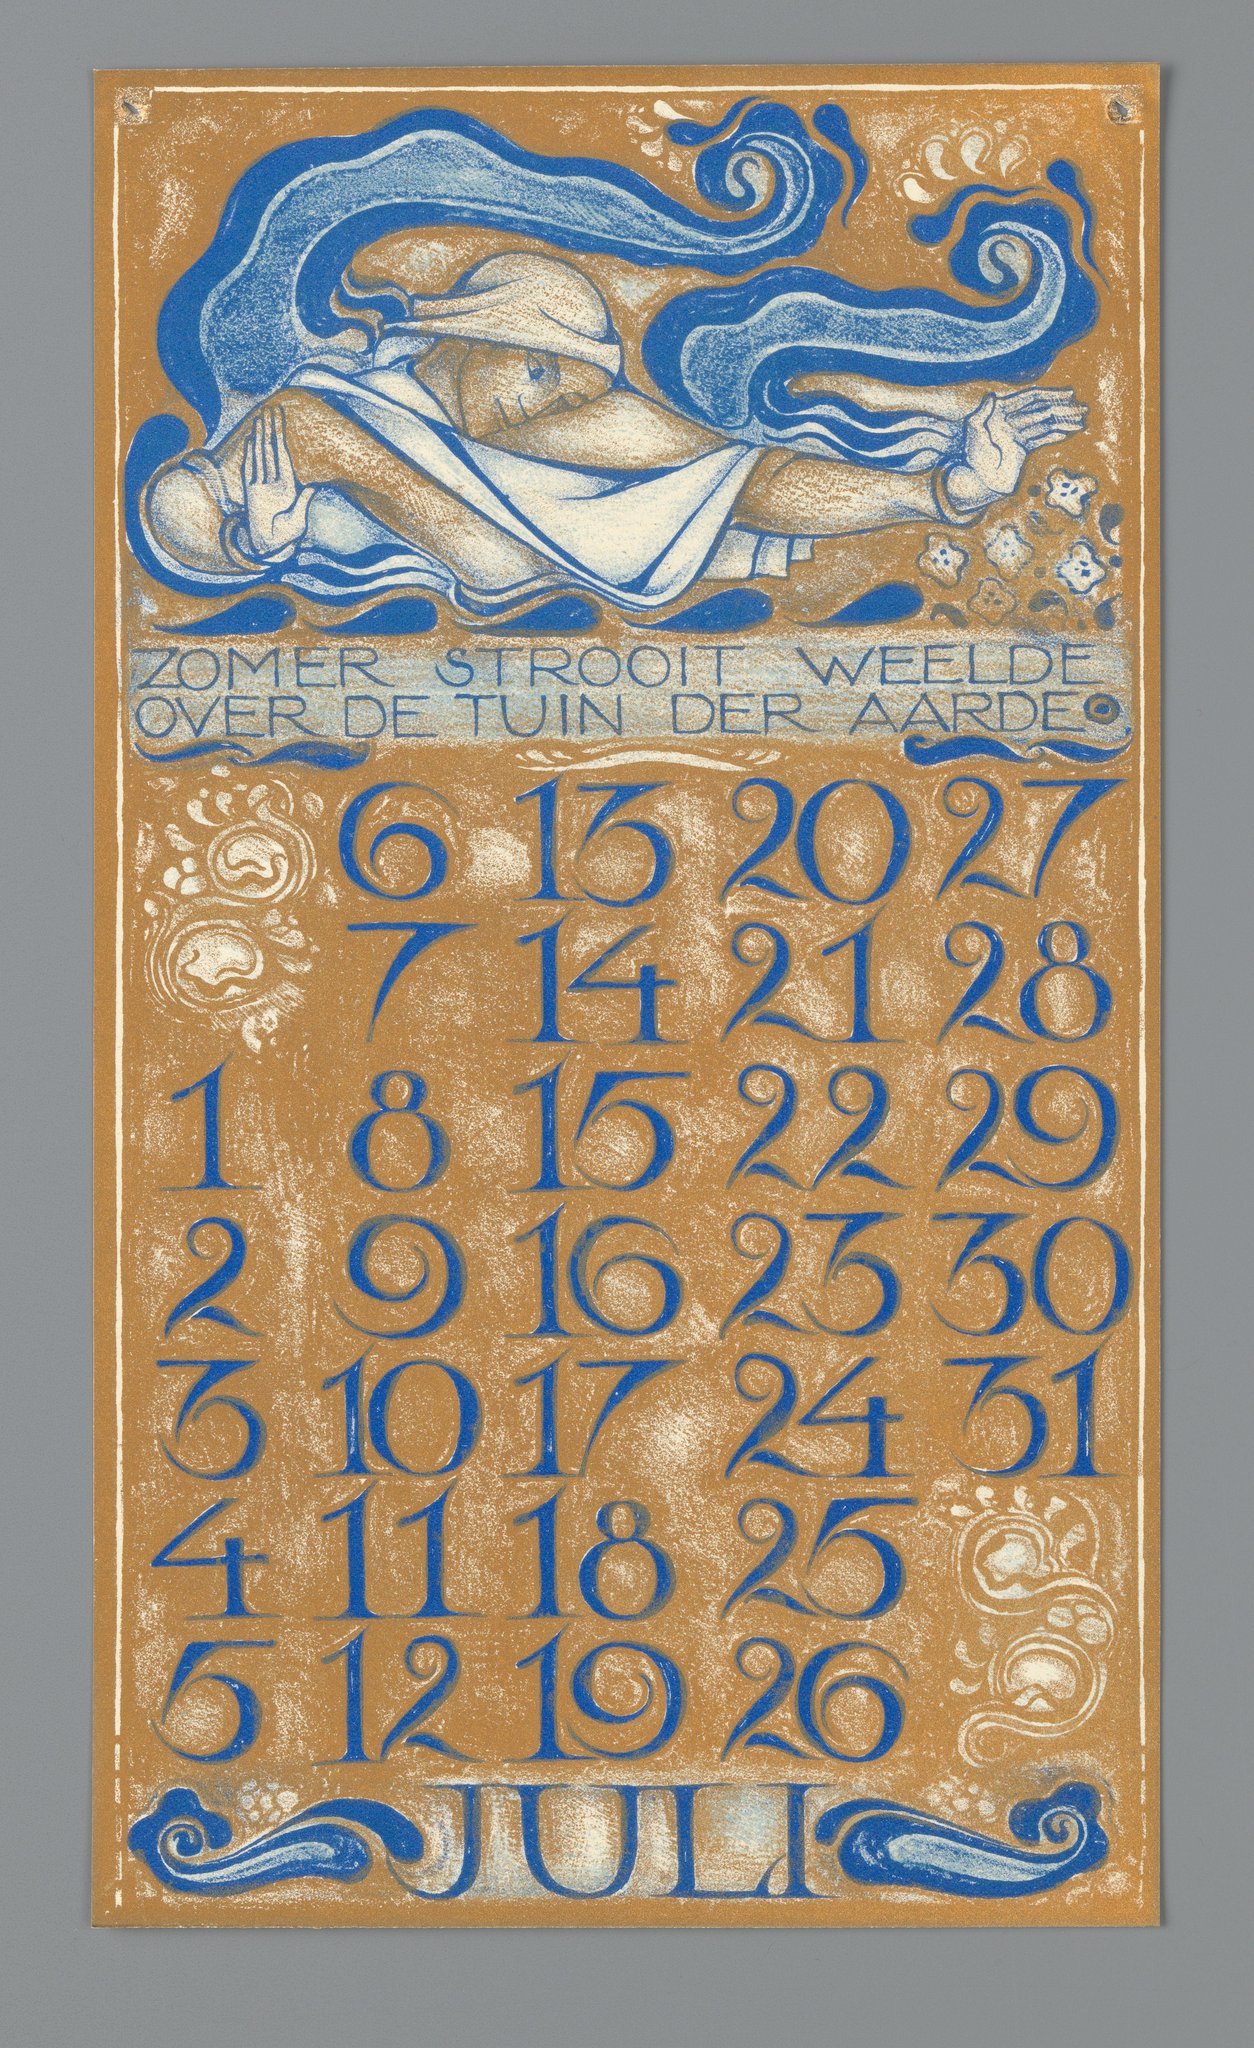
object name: calendar leaf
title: Kalenderblad voor juli 1930 van de Nederlandsch Kunstverbond Kalender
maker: willem arondéus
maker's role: draughtsman, print maker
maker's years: 1894-1943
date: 1929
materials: paper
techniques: lithograph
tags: flowers, calendar, almanac, adult woman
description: Een vrouw die bloemen uitstrooit, bij de spreuk: 'Zomer strooit weelde over de tuin der aarde'. Daaronder de maandcijfers en kleine golvende decoraties.